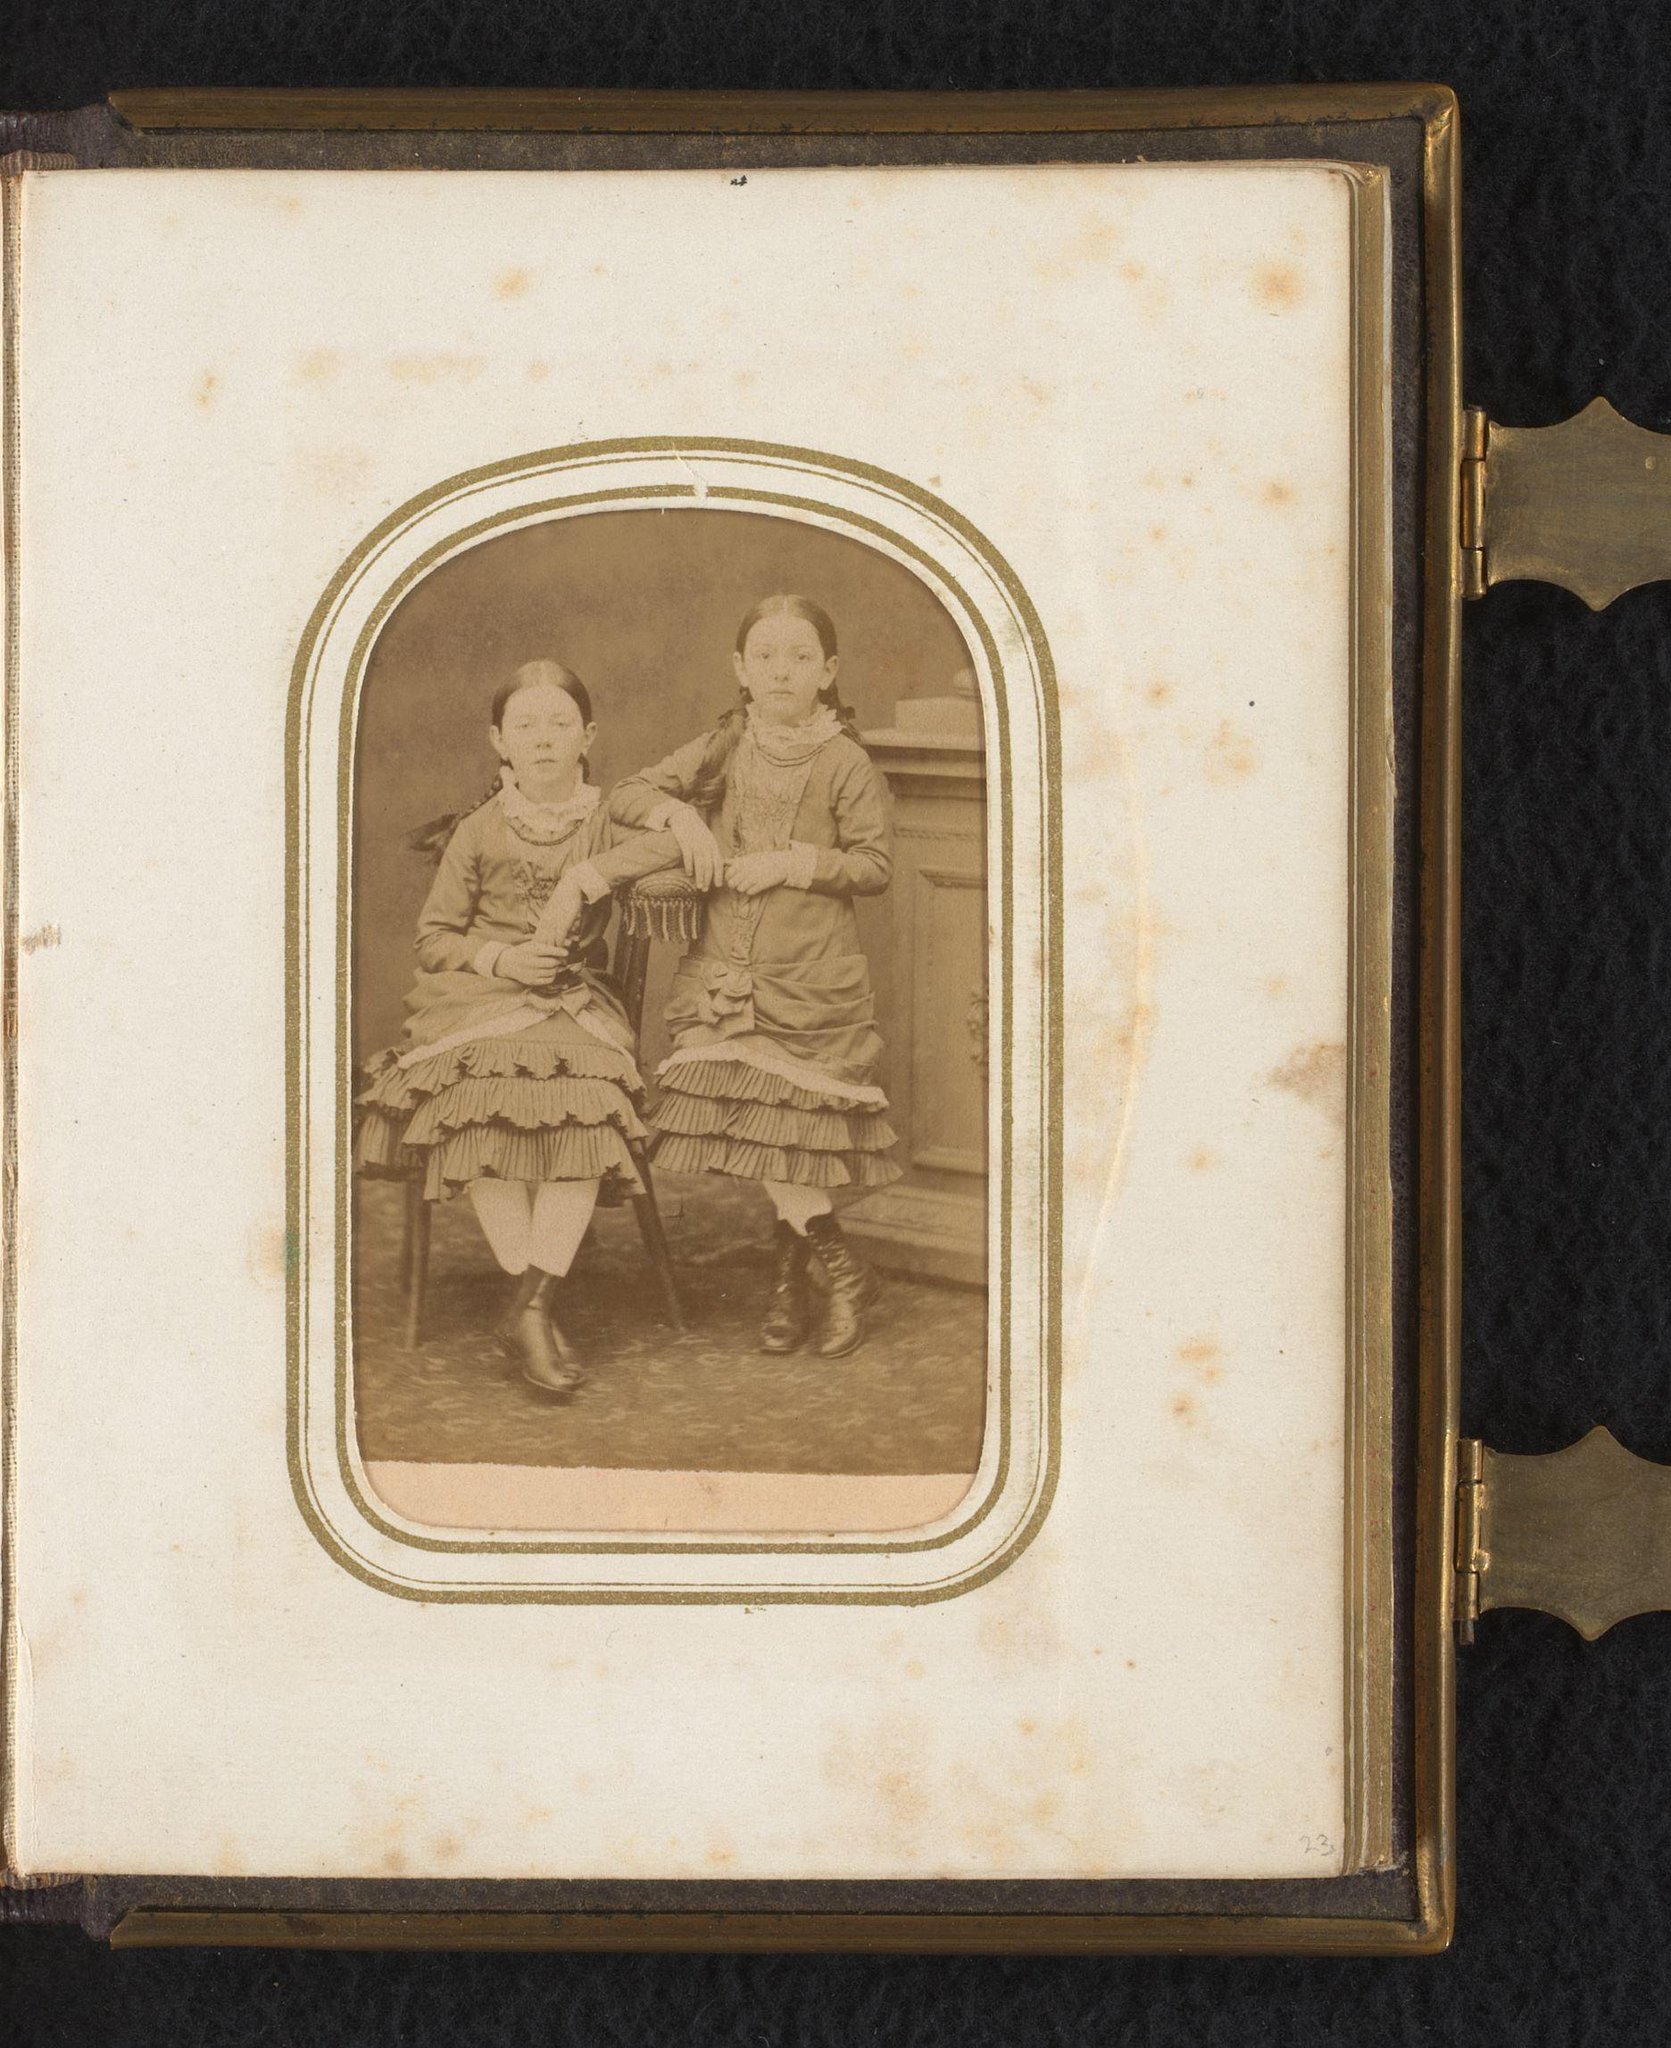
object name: photograph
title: Portret van twee meisjes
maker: lodewijk hendrikus serré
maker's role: fotograaf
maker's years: 1847-1897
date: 1877-1897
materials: cardboard, photographic support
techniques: albumen print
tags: historical persons, girl (child between toddler and youth)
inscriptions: inscription: ‘L. H. Serré/ Photographe/ Utrecht, Nachtegaalstraat/ voor het park Tivoli, No 20 en 's Hage (...)’